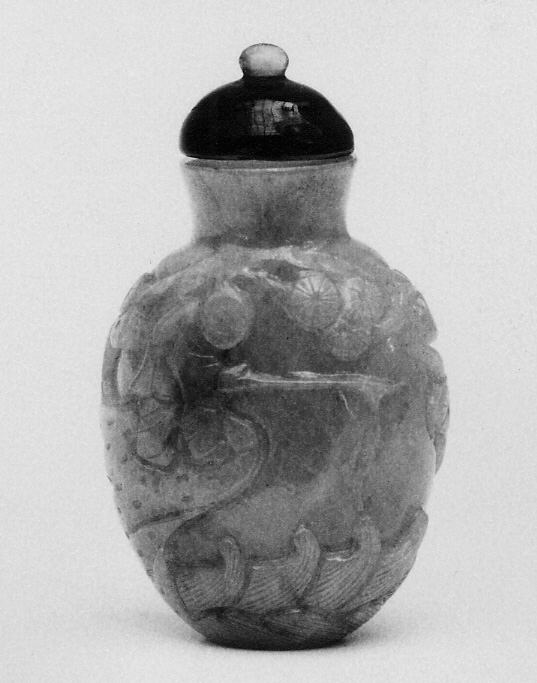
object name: snuff bottle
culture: chinese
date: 1701-1800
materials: jade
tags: men,fishing